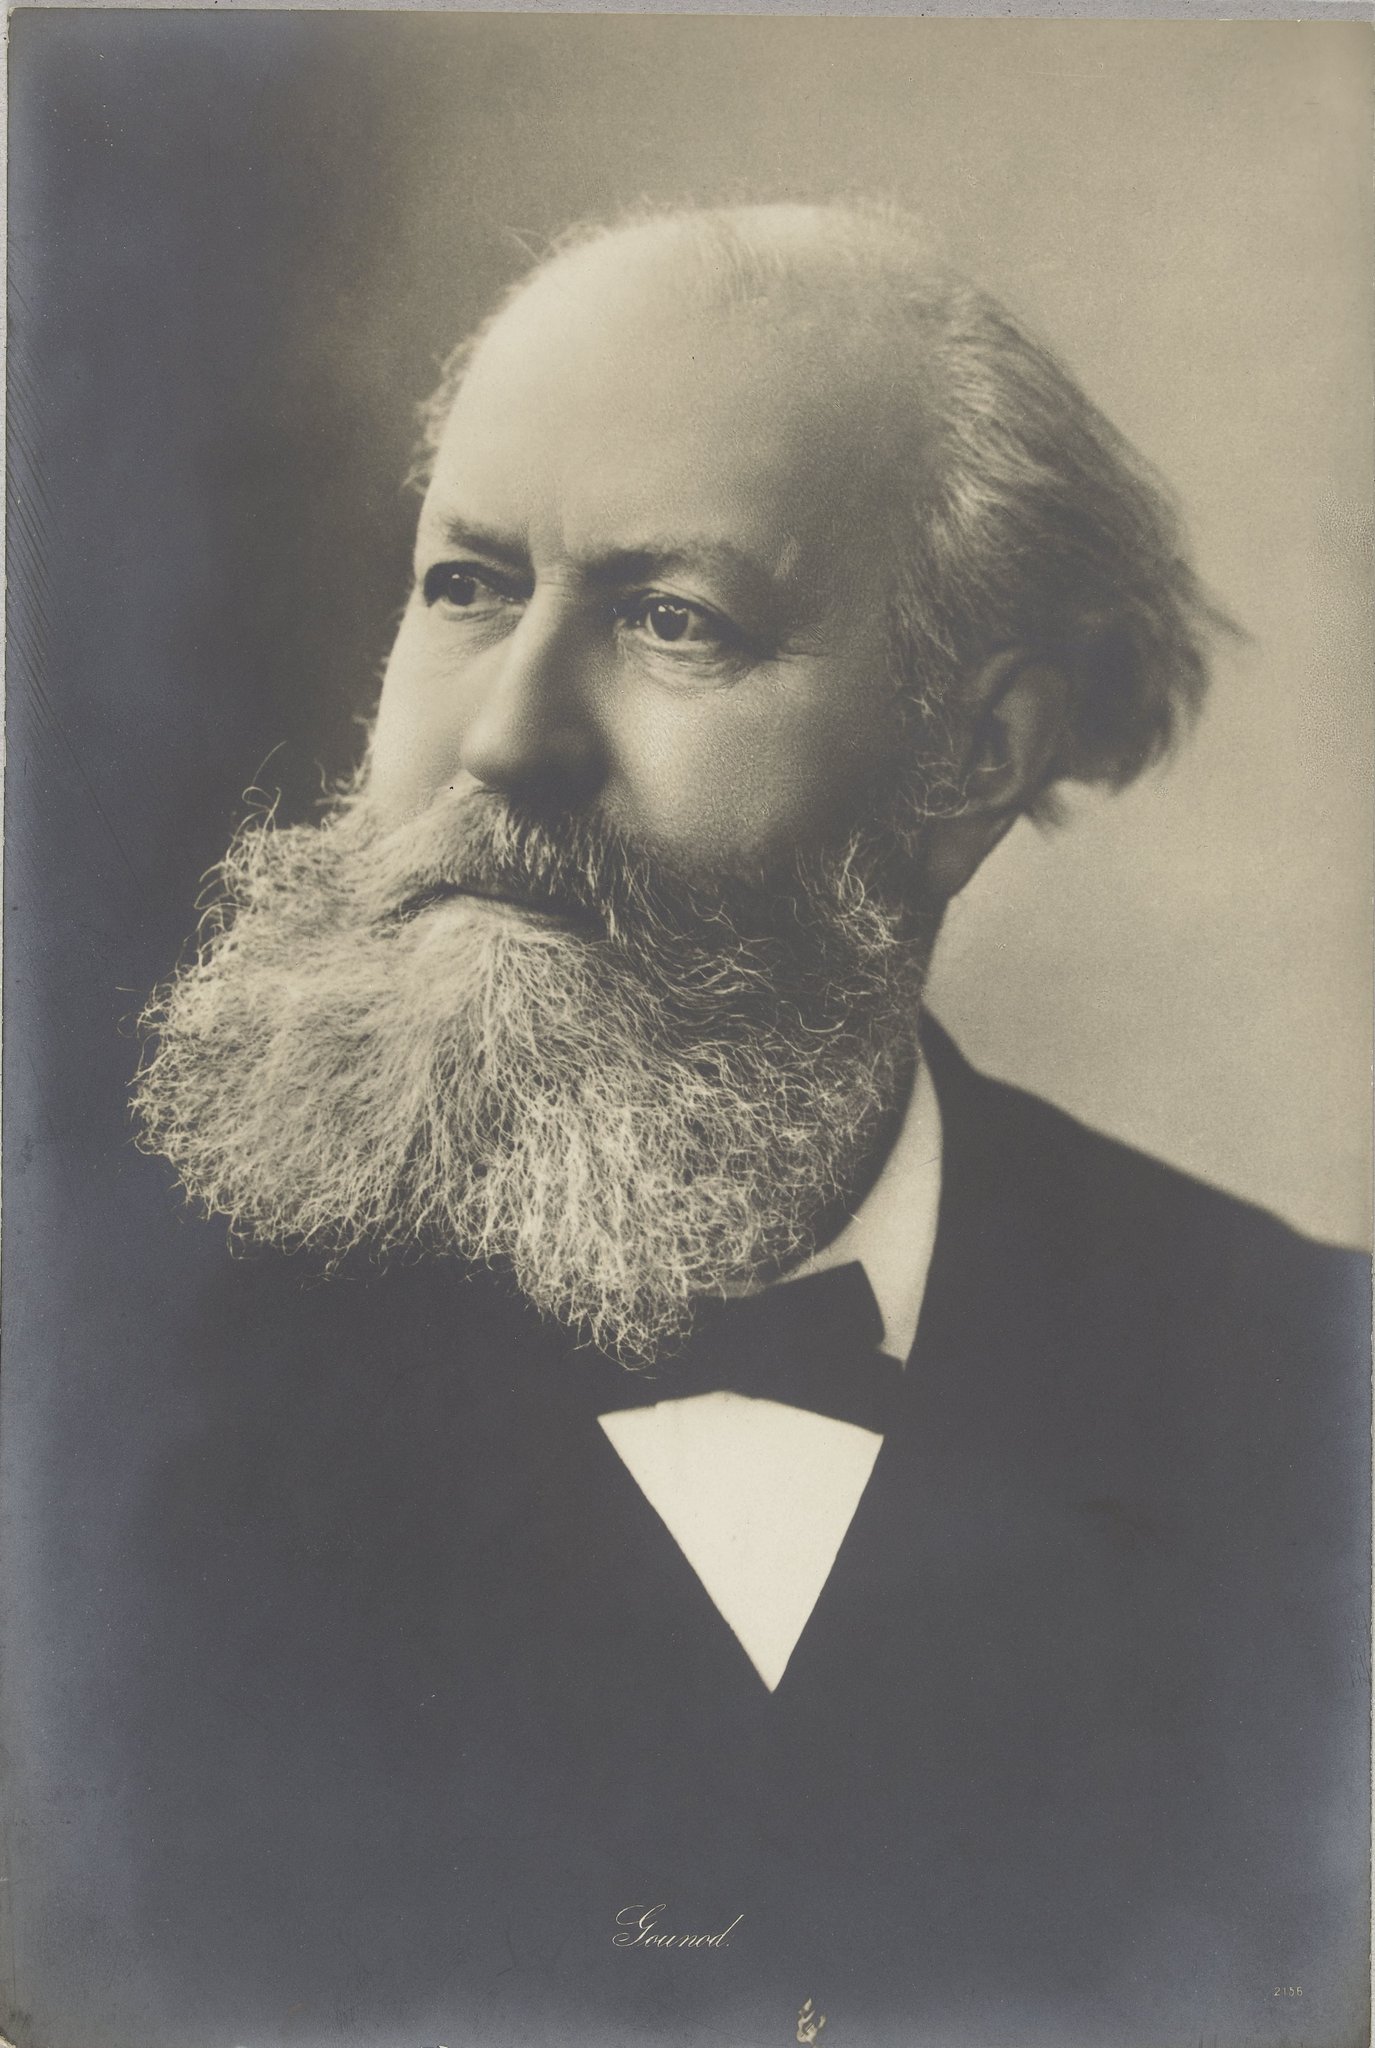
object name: photograph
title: Gounod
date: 1880-1900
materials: paper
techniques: matte daylight collodion silver print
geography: the hague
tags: historical persons, portrait of composer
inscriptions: name: ‘Gounod’, name: ‘Rijshouwer's Establishment fromerly Parson. Photographs etc. 11 Lange Poten - the Hague. Holland’